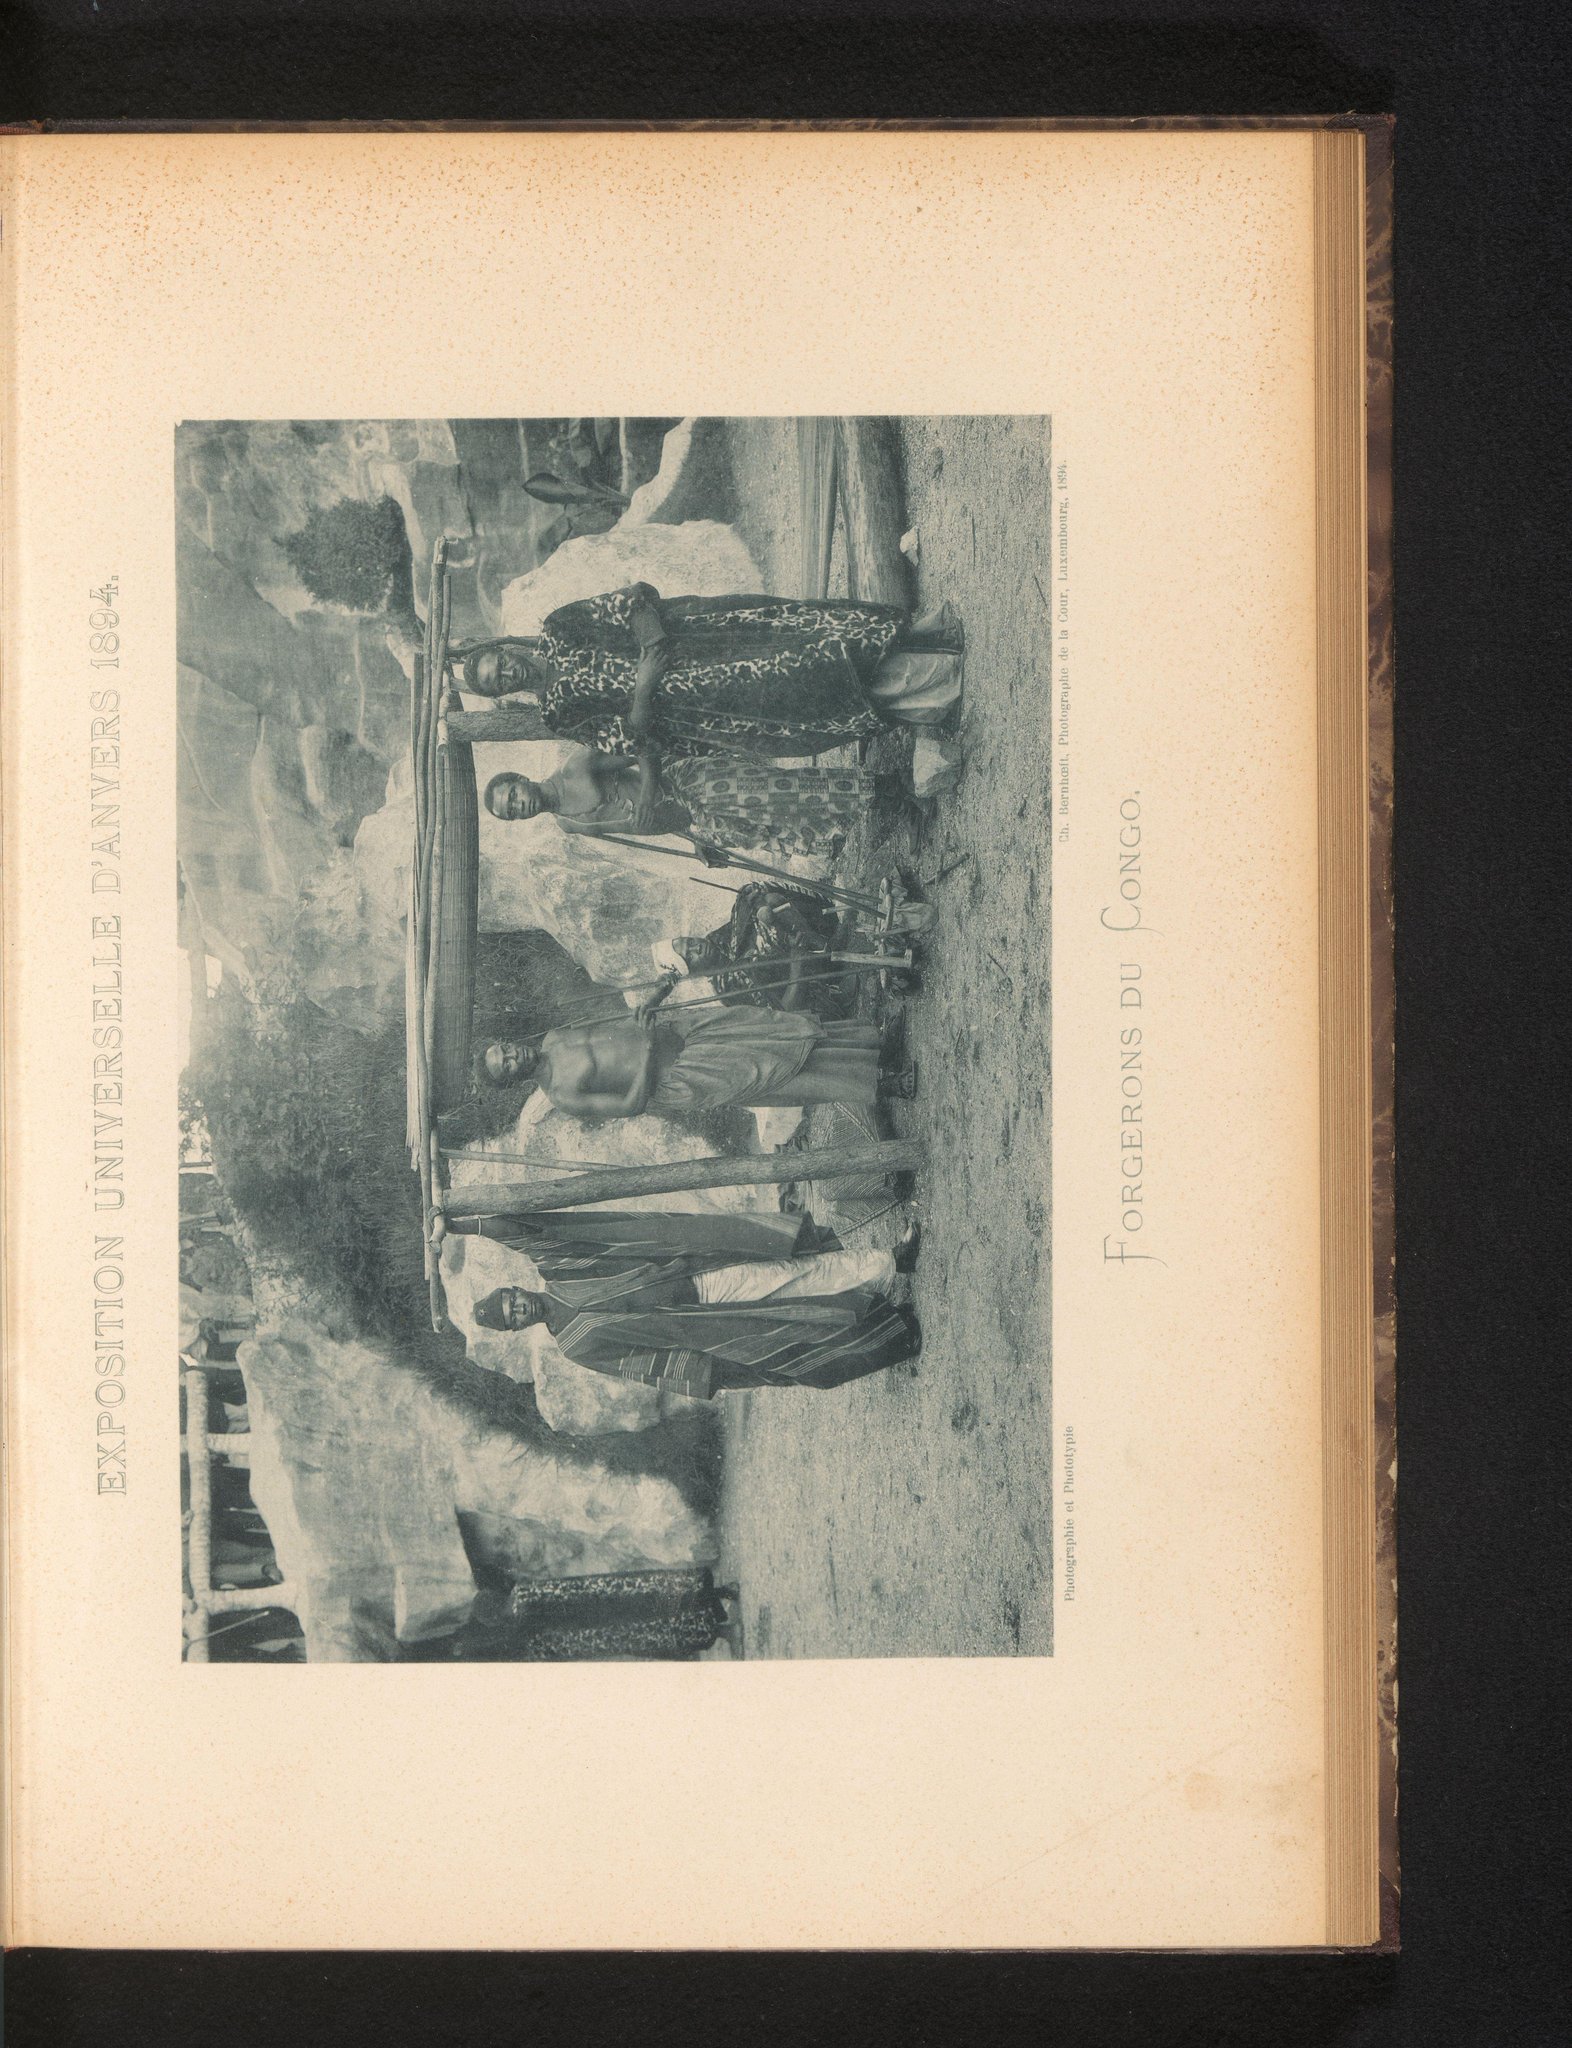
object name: page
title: Exposition Universelle d'Anvers 1894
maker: charles bernhoeft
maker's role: publisher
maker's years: 1859-1933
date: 1894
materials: paper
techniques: photograph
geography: luxembourg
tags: world fair, world exhibition, adult man, smith, blacksmith, antwerp